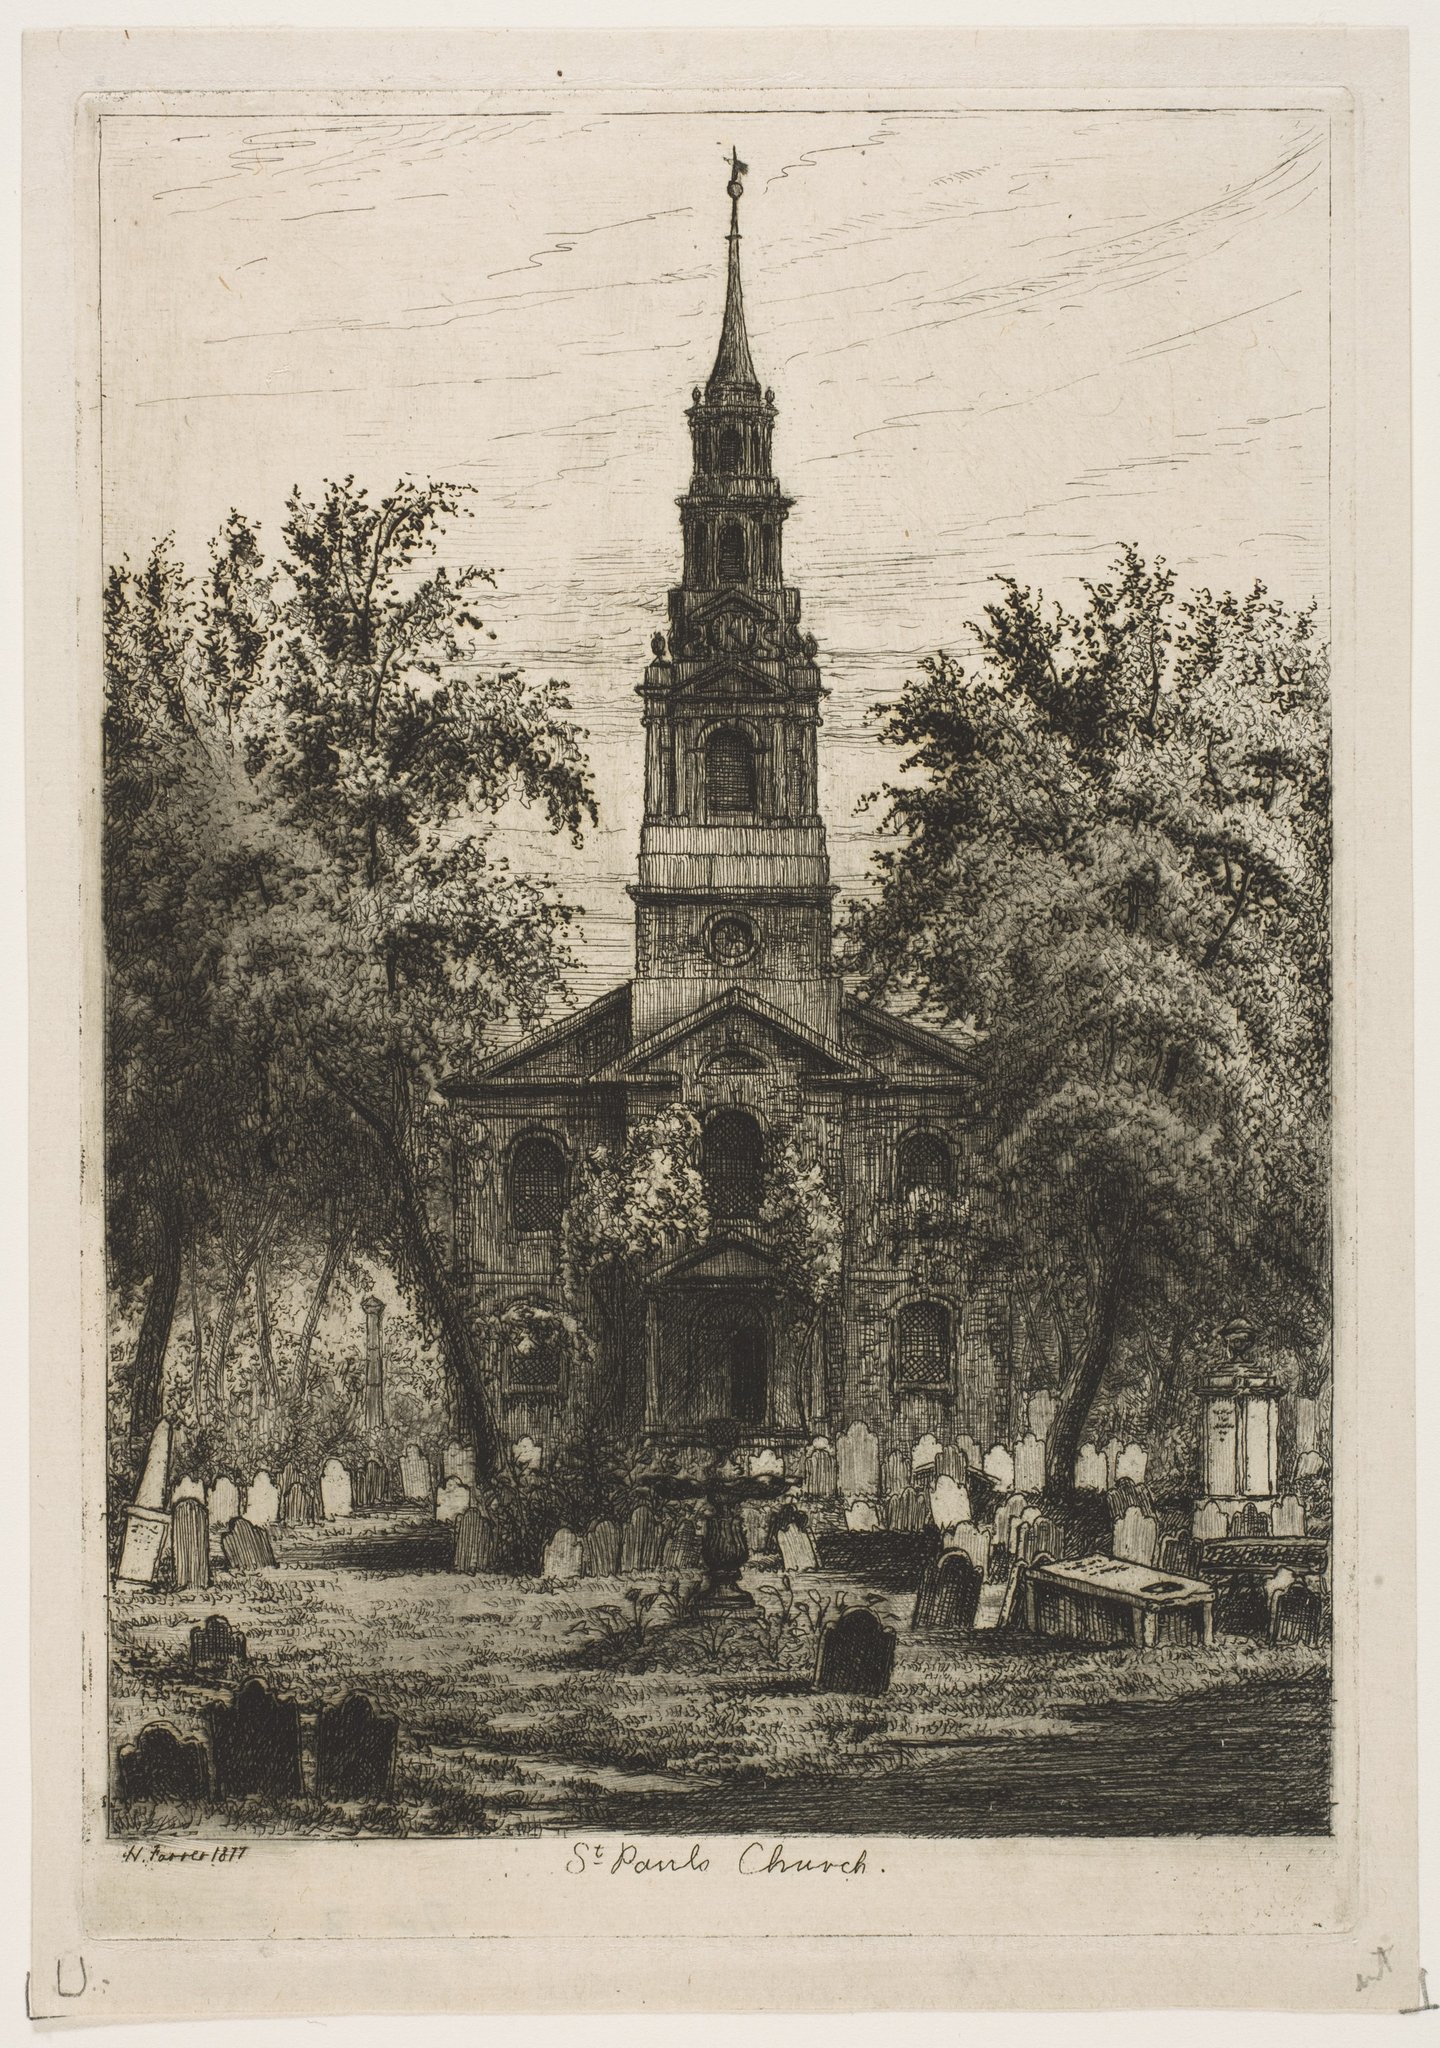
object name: print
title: St. Paul's Chapel, New York, from "Scenes of Old New York"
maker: henry farrer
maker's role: artist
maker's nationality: american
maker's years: 1844-1903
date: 1877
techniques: etching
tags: chapels,cemeteries,new york city